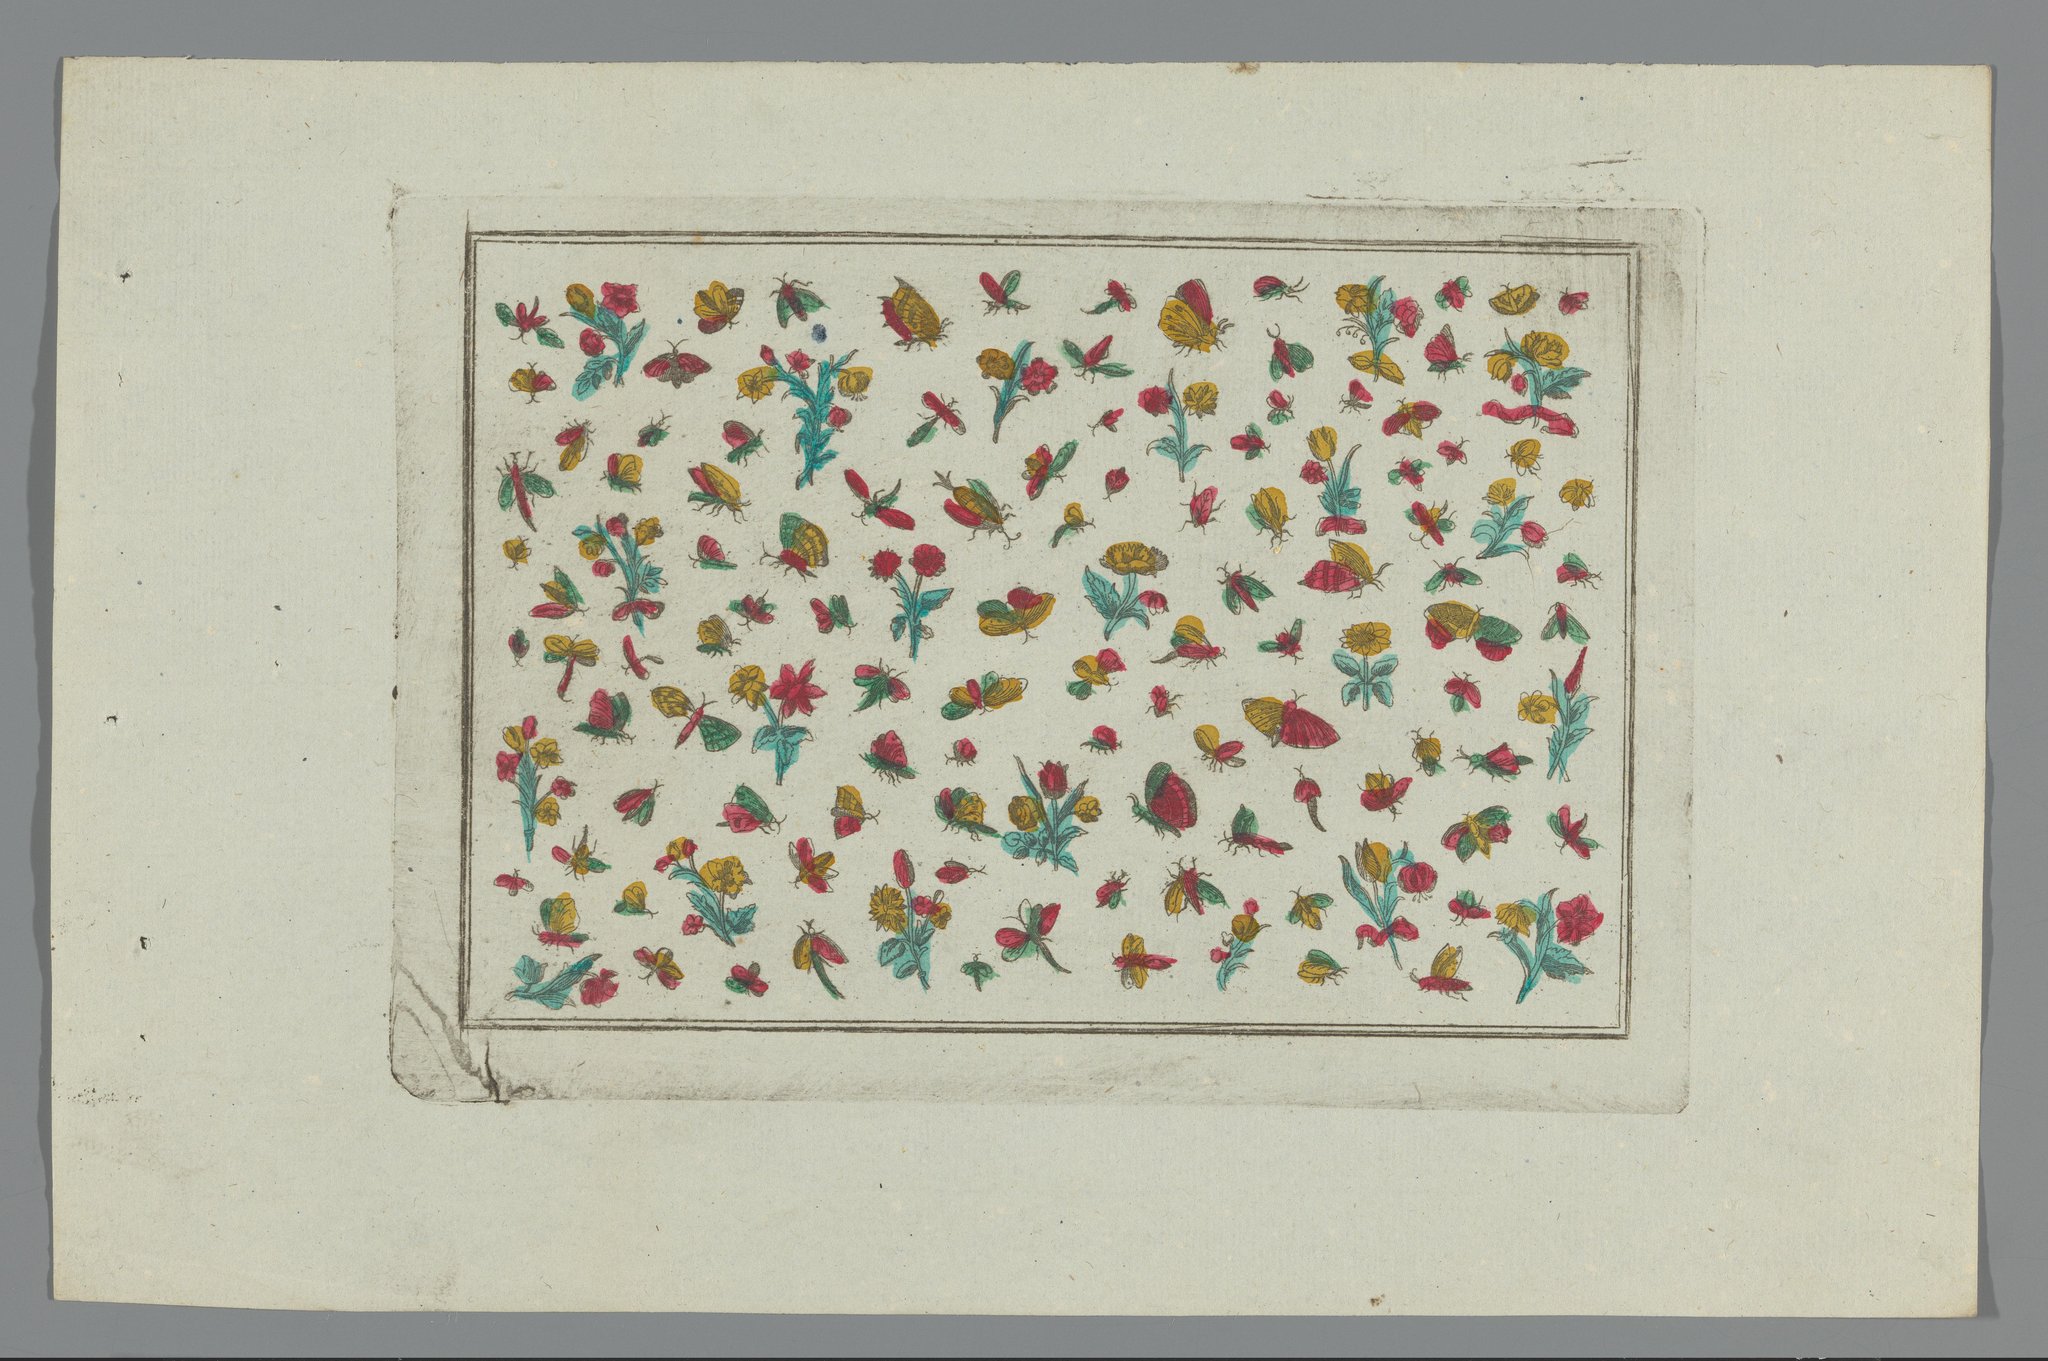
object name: print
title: Insecten en bloemen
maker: Anonymous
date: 1750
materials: paper, watercolor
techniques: etching, hand coloring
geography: paris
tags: flowers, insects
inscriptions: collector's mark: Lugt 2228, collector's mark: Lugt 2760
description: Blad met strooiveld van insecten en bloemen. Een van 39 bladen met knipplaatjes en decoratieve randen.